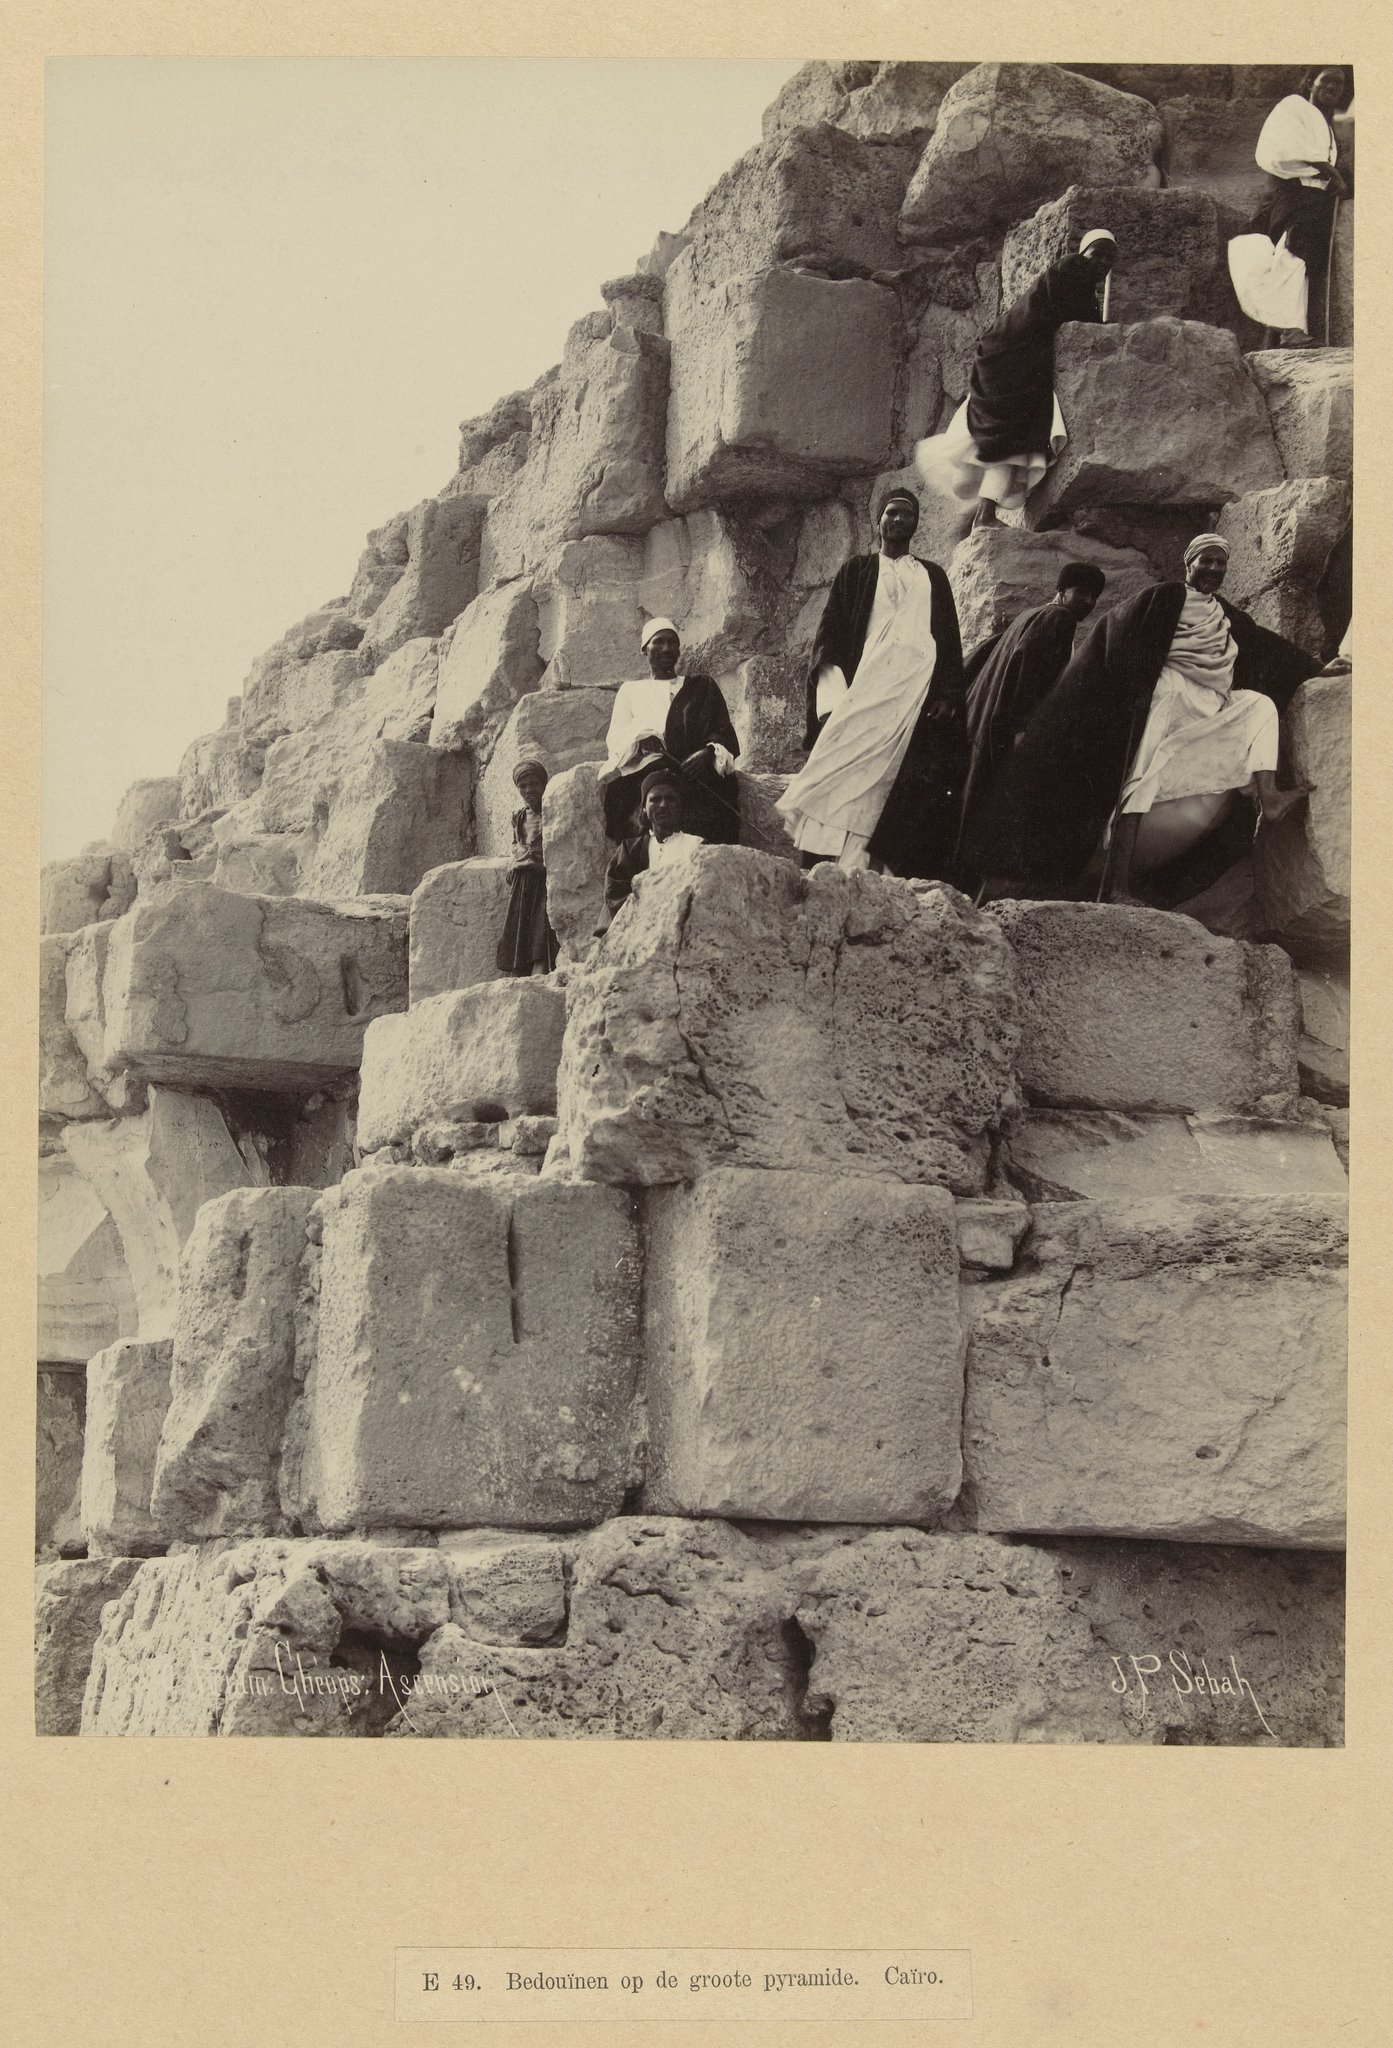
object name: photograph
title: E 49. Bedouïnen op de groote pyramide. Caïro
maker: jean pascal sébah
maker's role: fotograaf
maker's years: 1872-1947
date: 1888-1895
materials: cardboard, paper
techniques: albumen print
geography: gizeh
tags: climbing, pyramid (historical grave form)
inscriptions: title: ‘E 49. Bedouïnen op de groote pyramide. Caïro.’, number: ‘230 [?]’, stamp: ‘Gemeentelijke bibliotheek/ Rotterdam’, check stamp: ‘Bristol/ L.M.’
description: Onderdeel van een groep door fotograaf Richard Polak op reis verzamelde foto’s. Deze foto is samen met andere op zijn reizen verzamelde foto's tentoongesteld bij de Rotterdamsche Kunstkring (1895), Arti en Amicitiae te Amsterdam (1897-1898?) en Societeit 't Collegie te Kampen (datum vooralsnog onbekend).